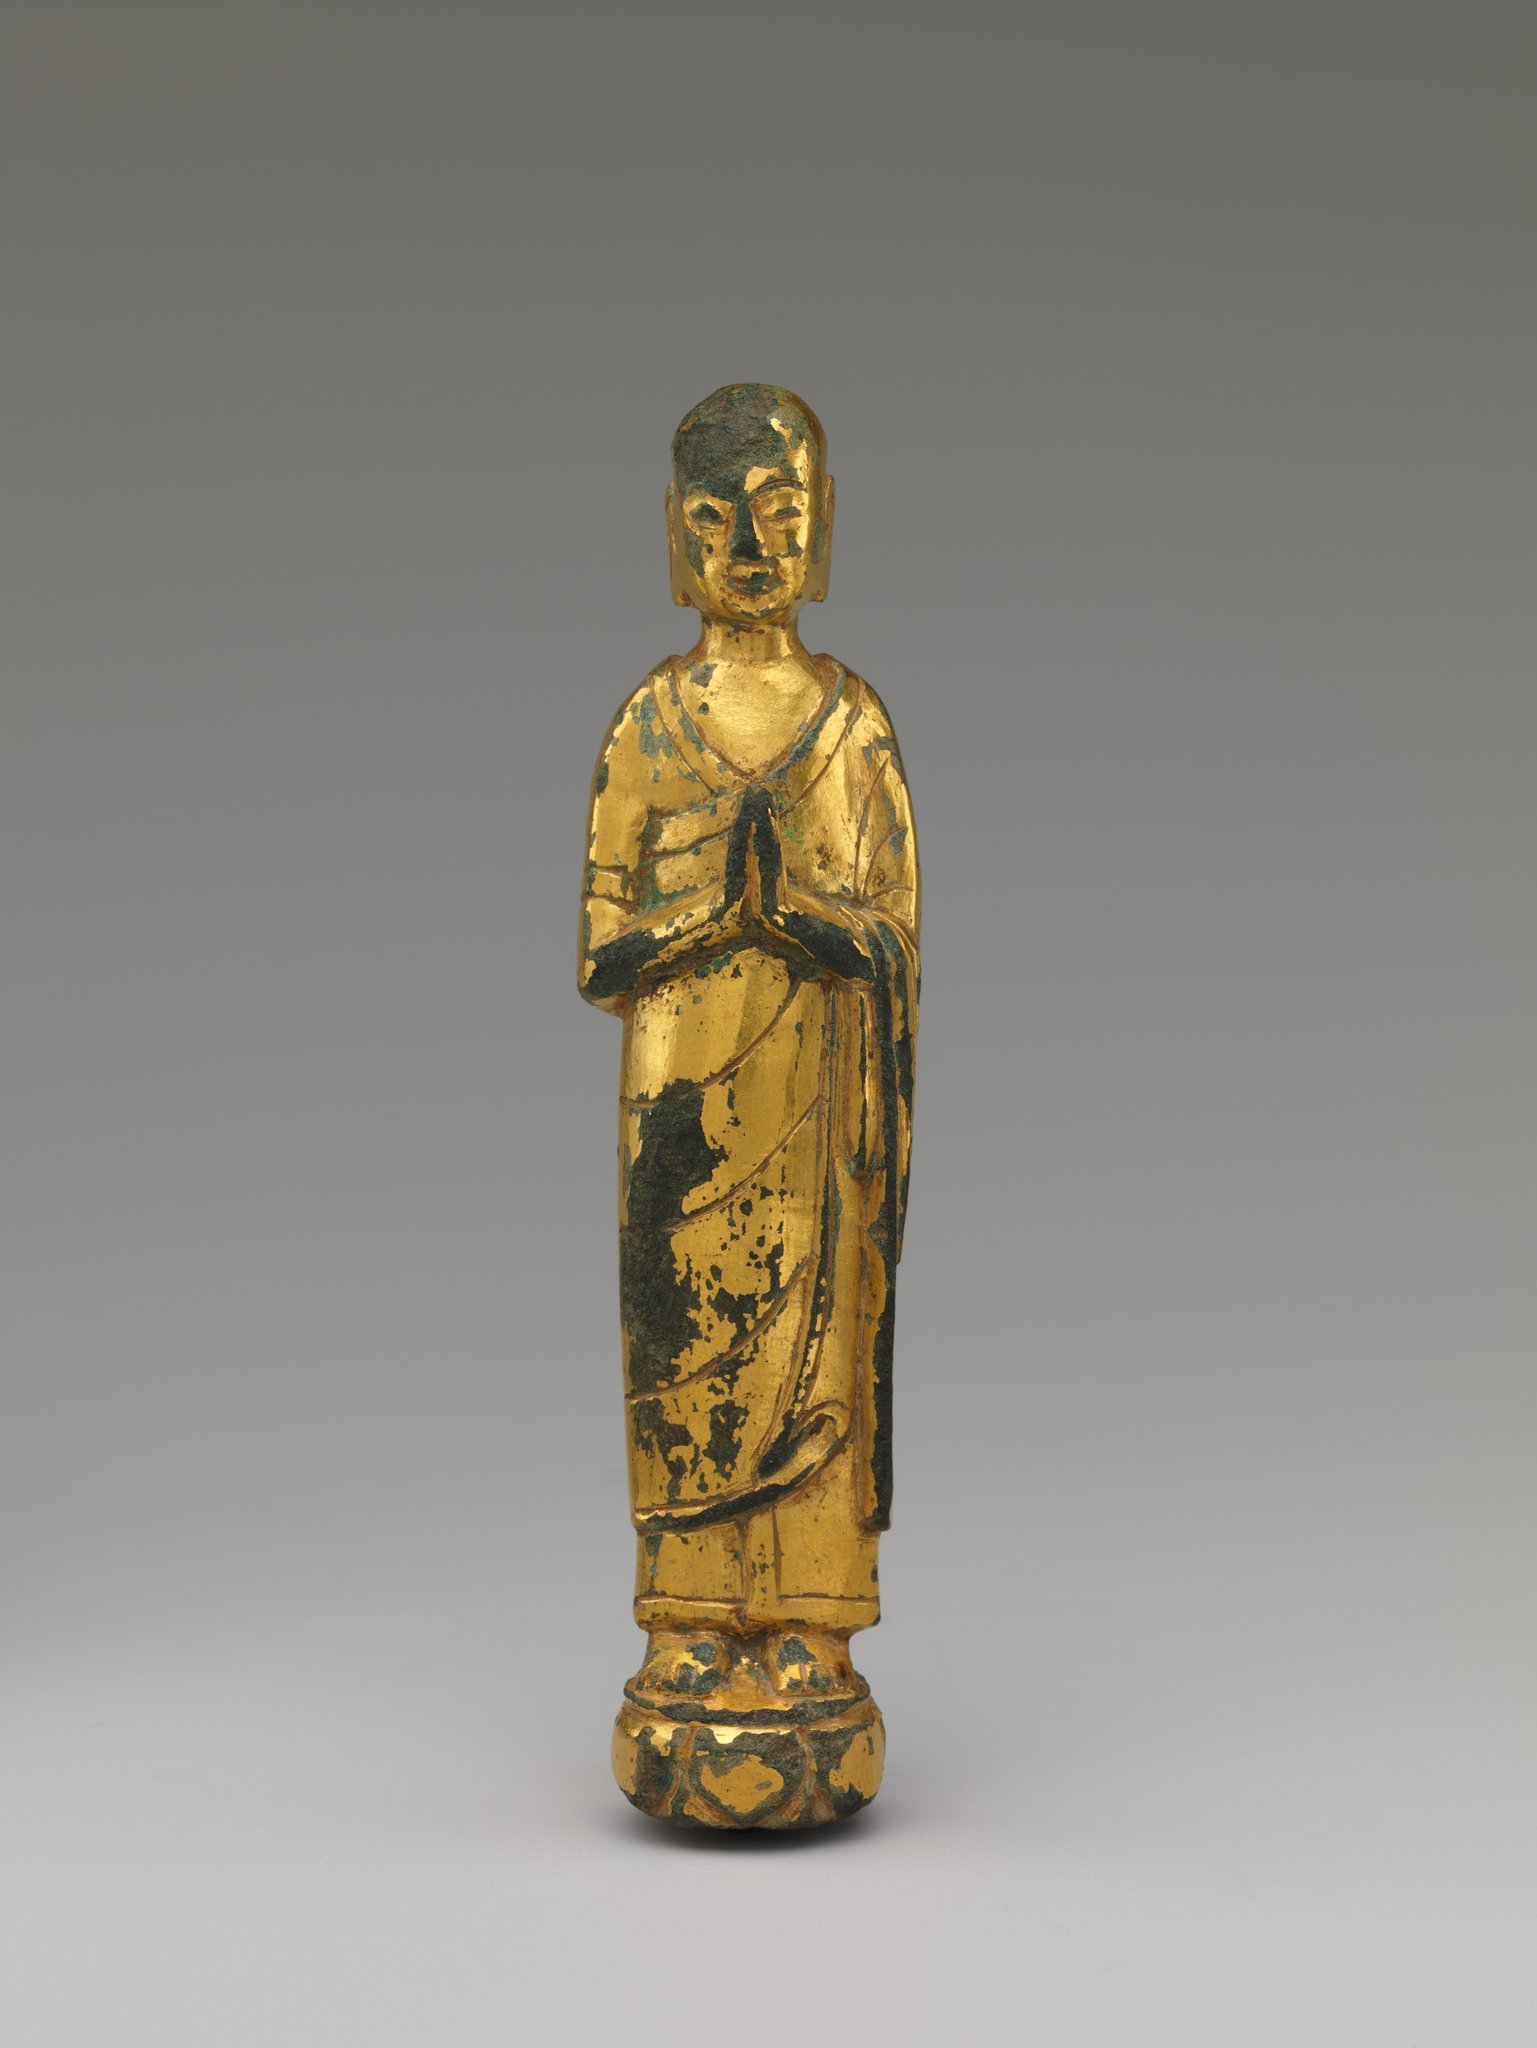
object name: figurine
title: Buddhist monk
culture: chinese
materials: bronze, gilt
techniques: casting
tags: monks